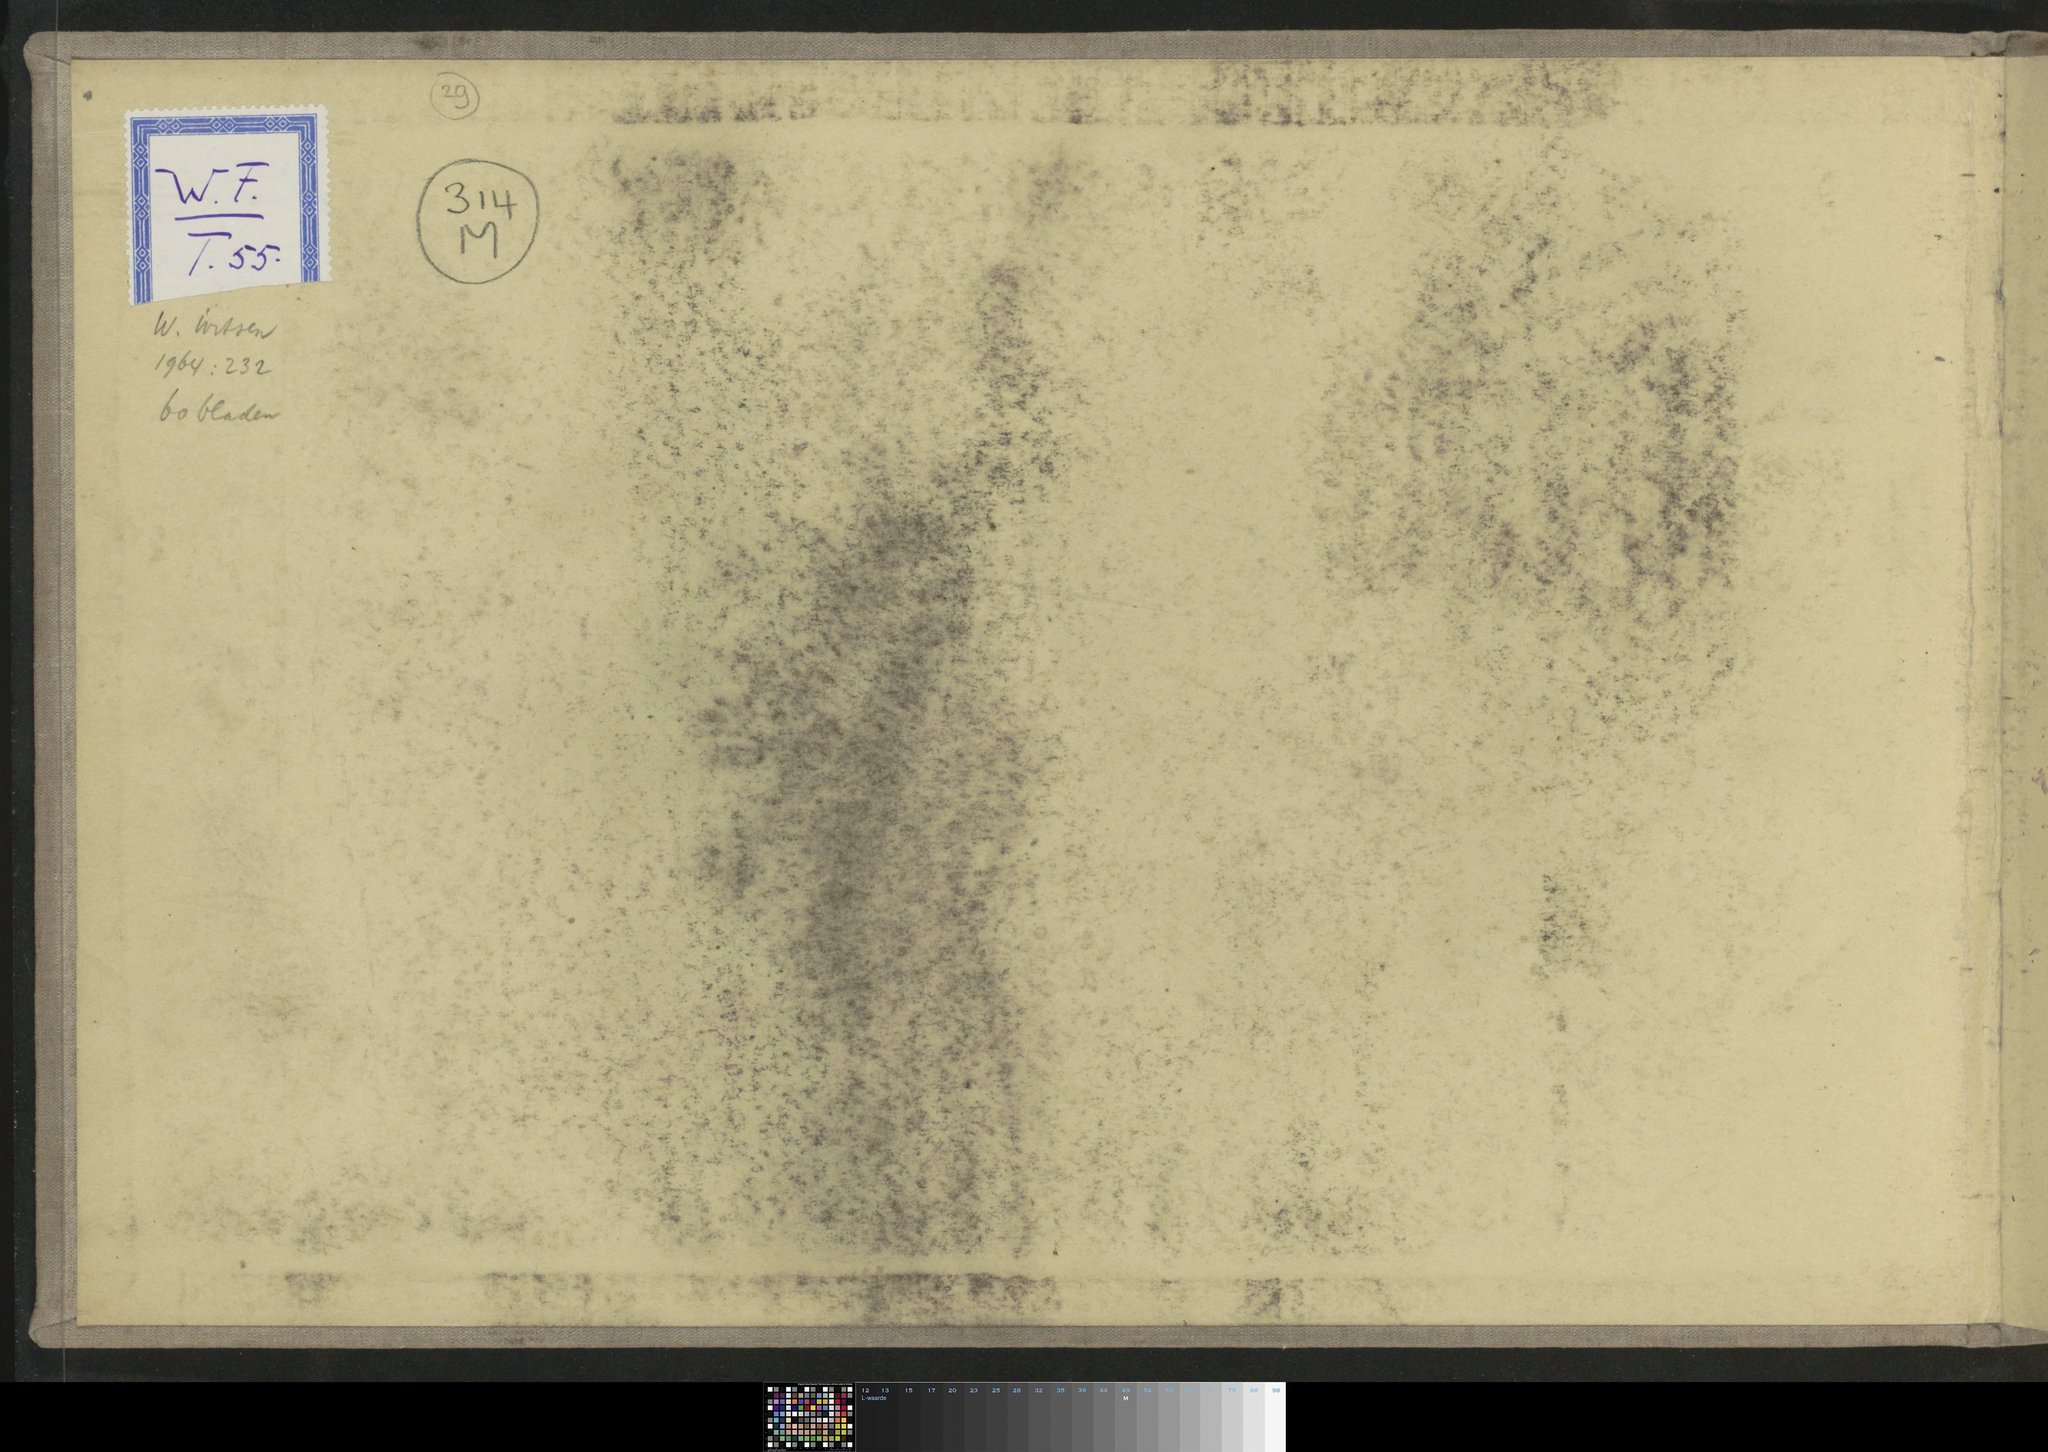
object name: endleaf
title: Abklatsch van de krijttekening op pagina 1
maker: willem witsen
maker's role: draughtsman, painter, print maker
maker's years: 1860-1923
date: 1901-1907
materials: paper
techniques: printmaking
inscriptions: annotation: ‘W.F./ T 55.’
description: Schutblad A, voorste schutblad, uit een schetsboek met 60 bladen.